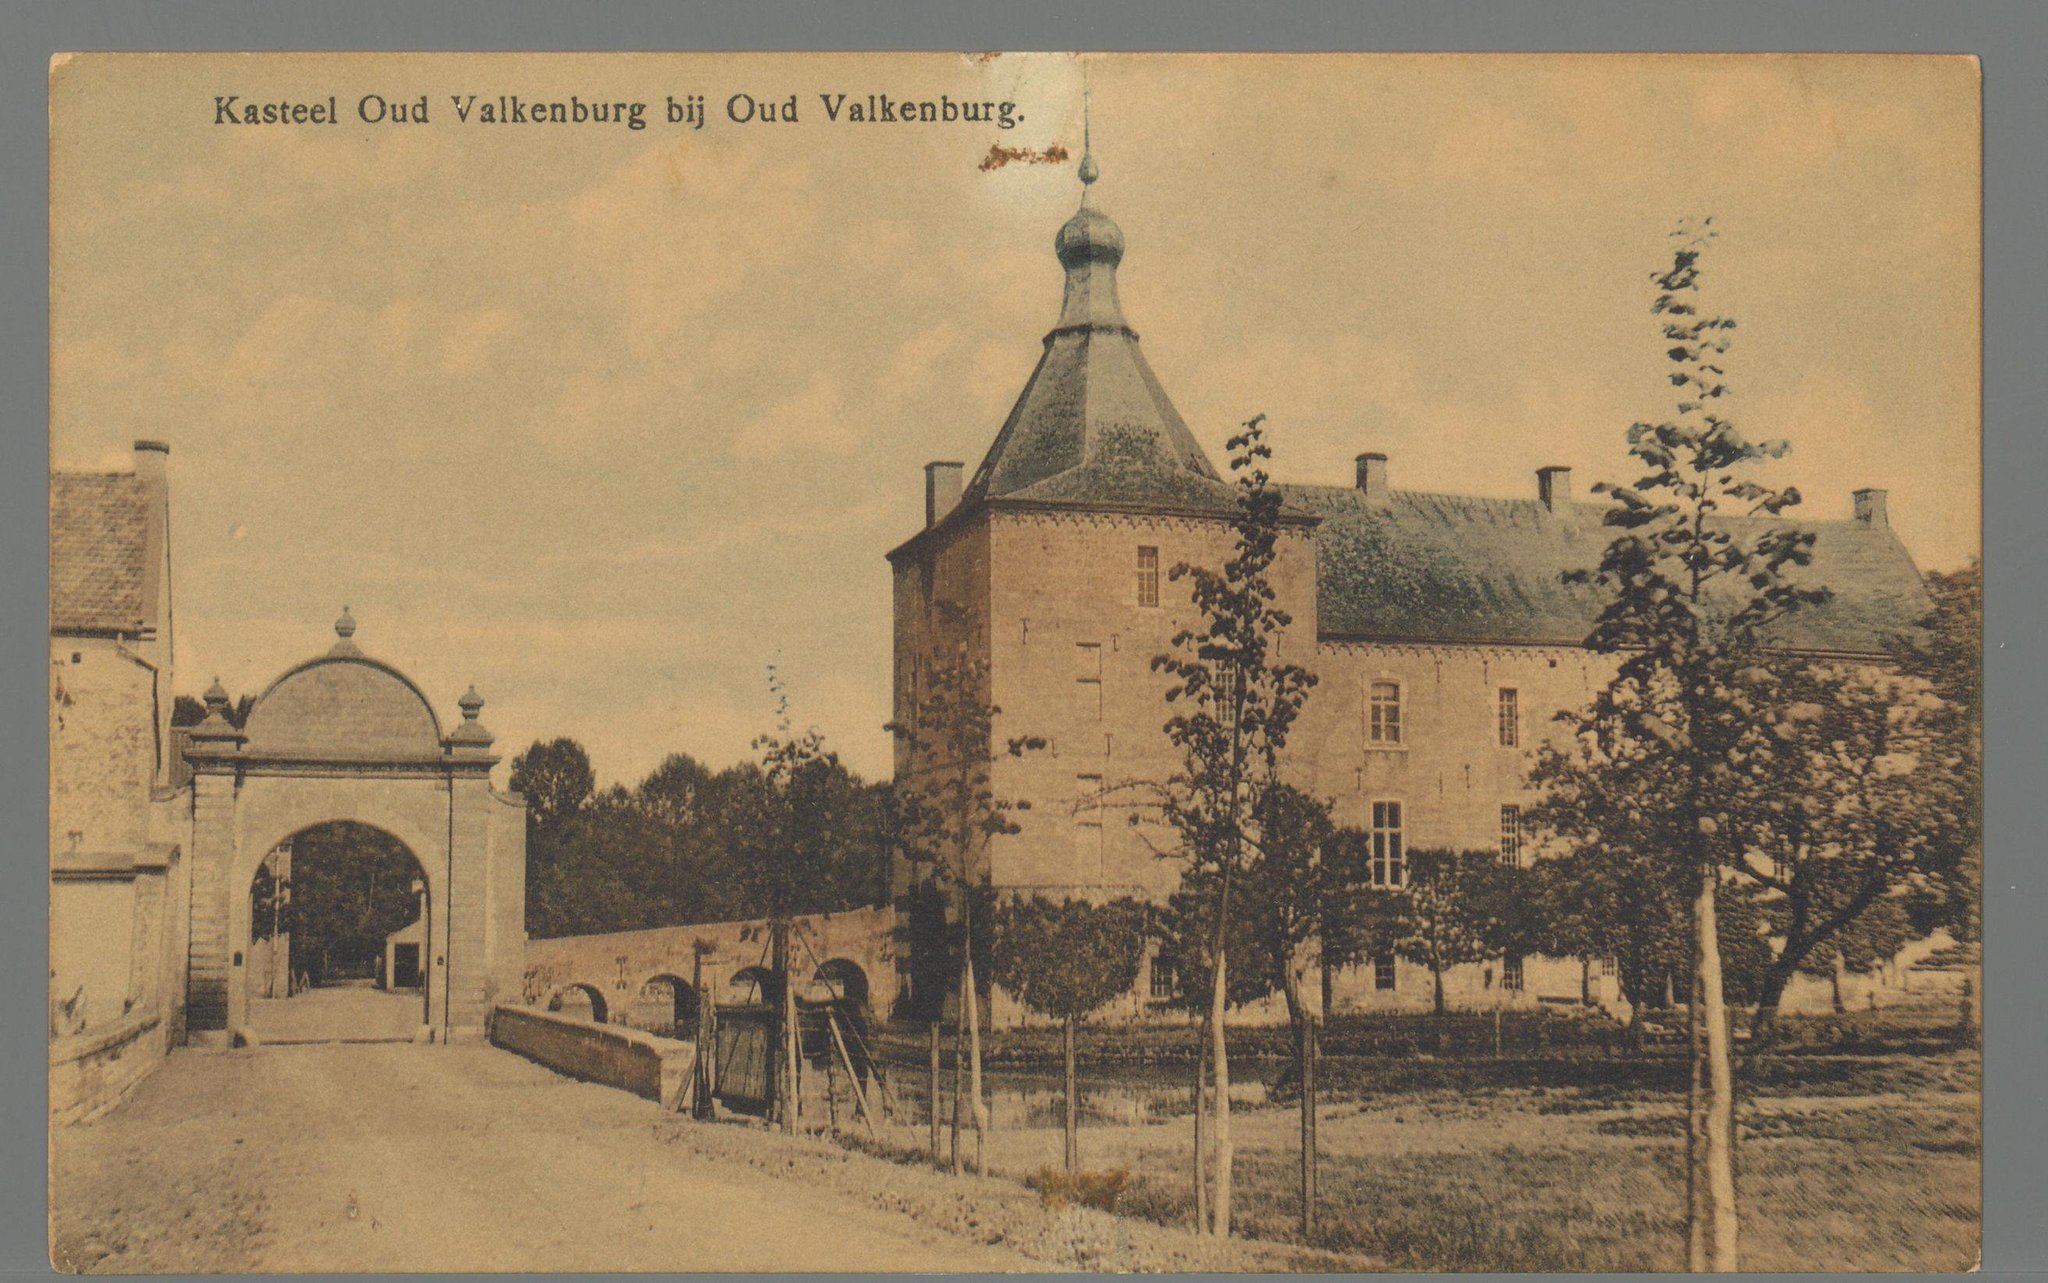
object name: ansichtkaart, prentbriefkaart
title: Kasteel Oud Valkenburg bij Oud Valkenburg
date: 1905-1930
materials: cardboard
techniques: collotype process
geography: amsterdam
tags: castle, gate, entrance